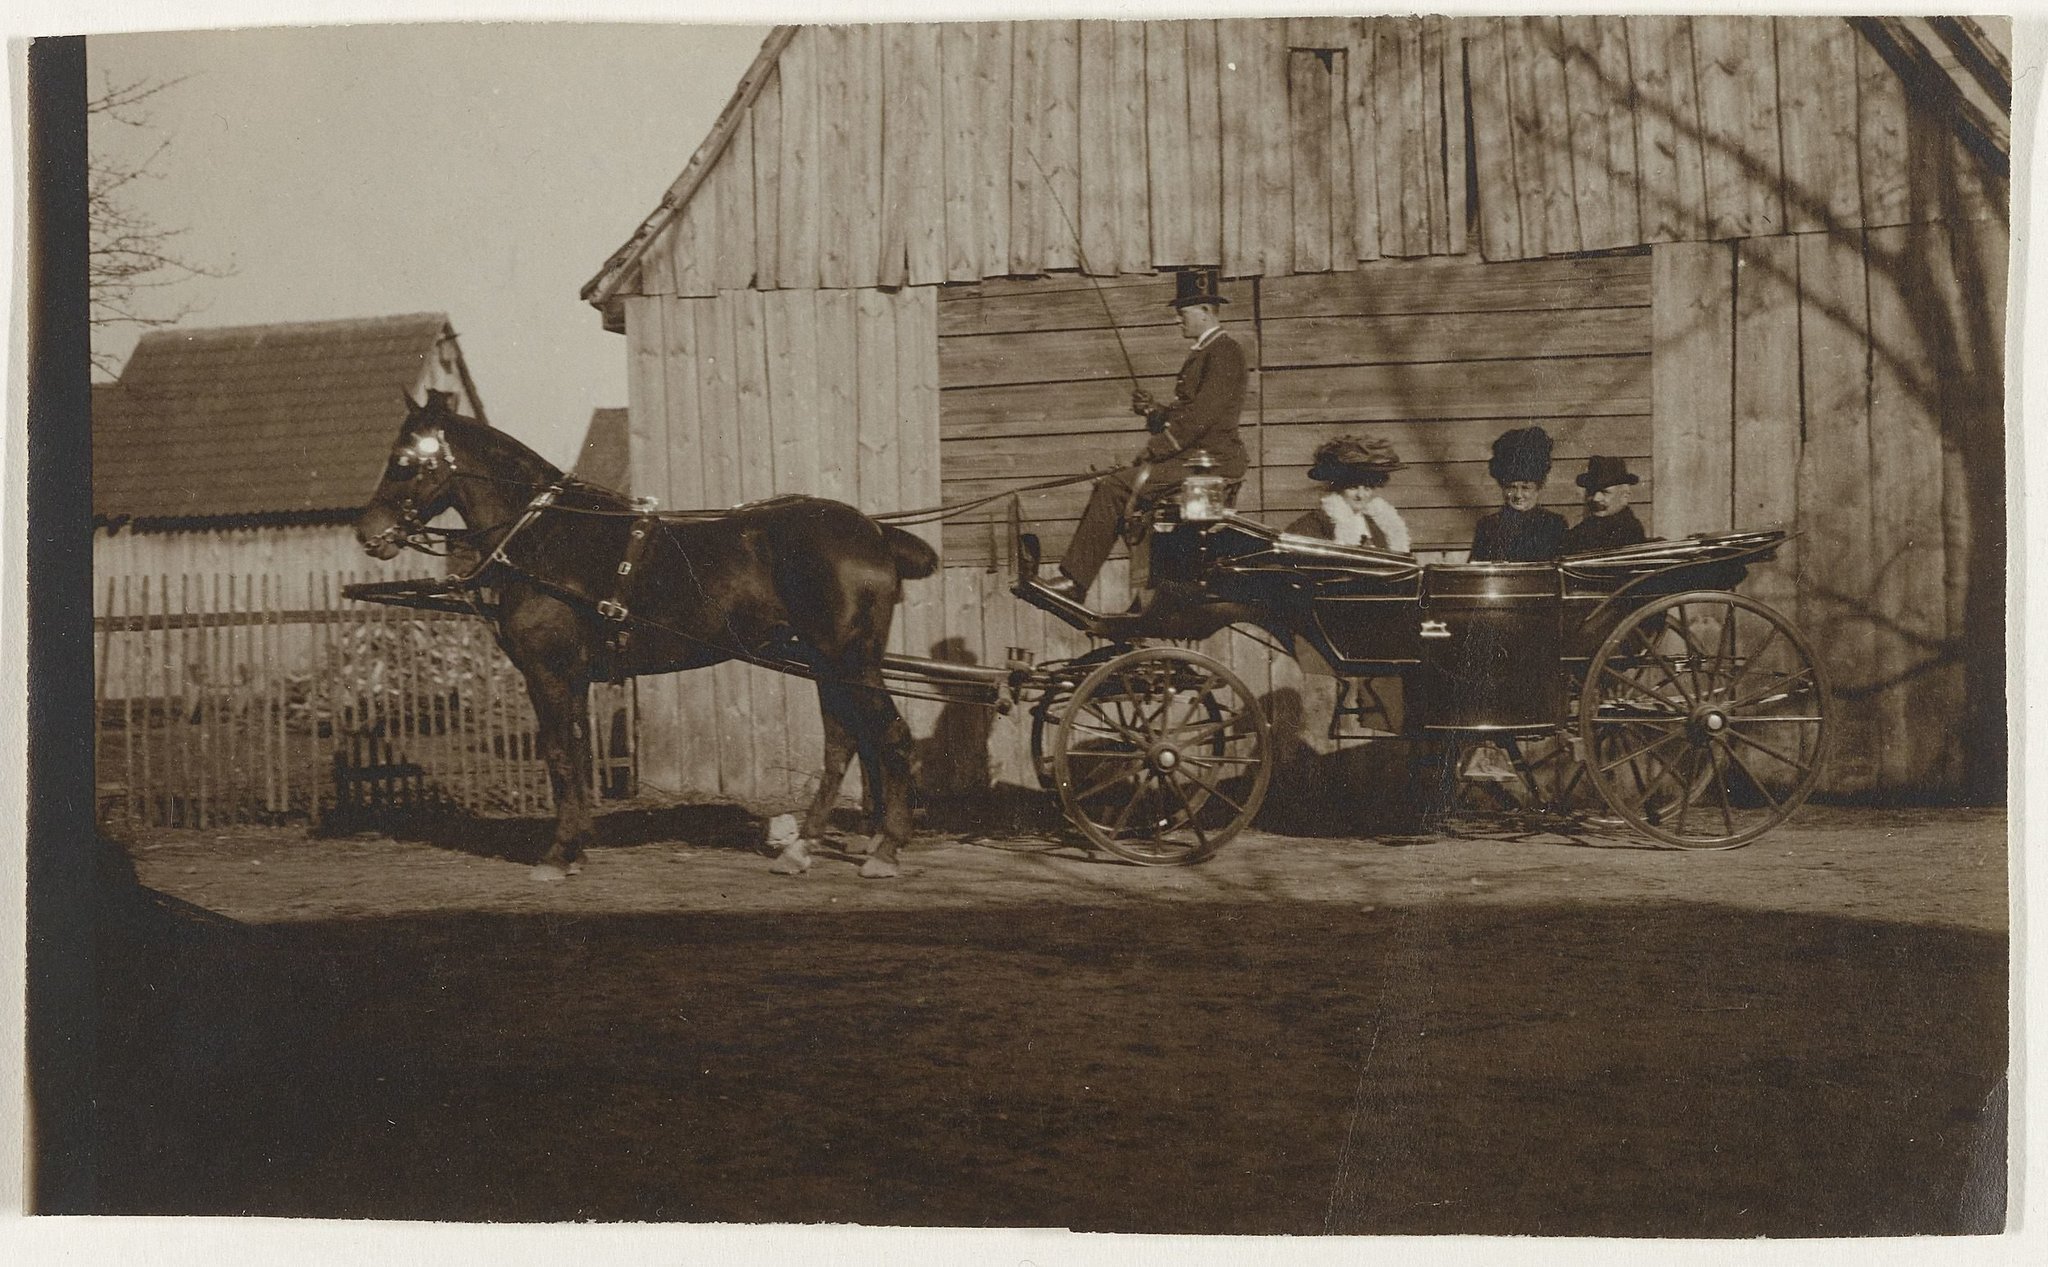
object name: photograph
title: Paard en koets met koetsier, twee vrouwen en een man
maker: Anonymous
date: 1900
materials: paper, photographic support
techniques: gelatin silver print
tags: four-wheeled vehicle drawn by one animal